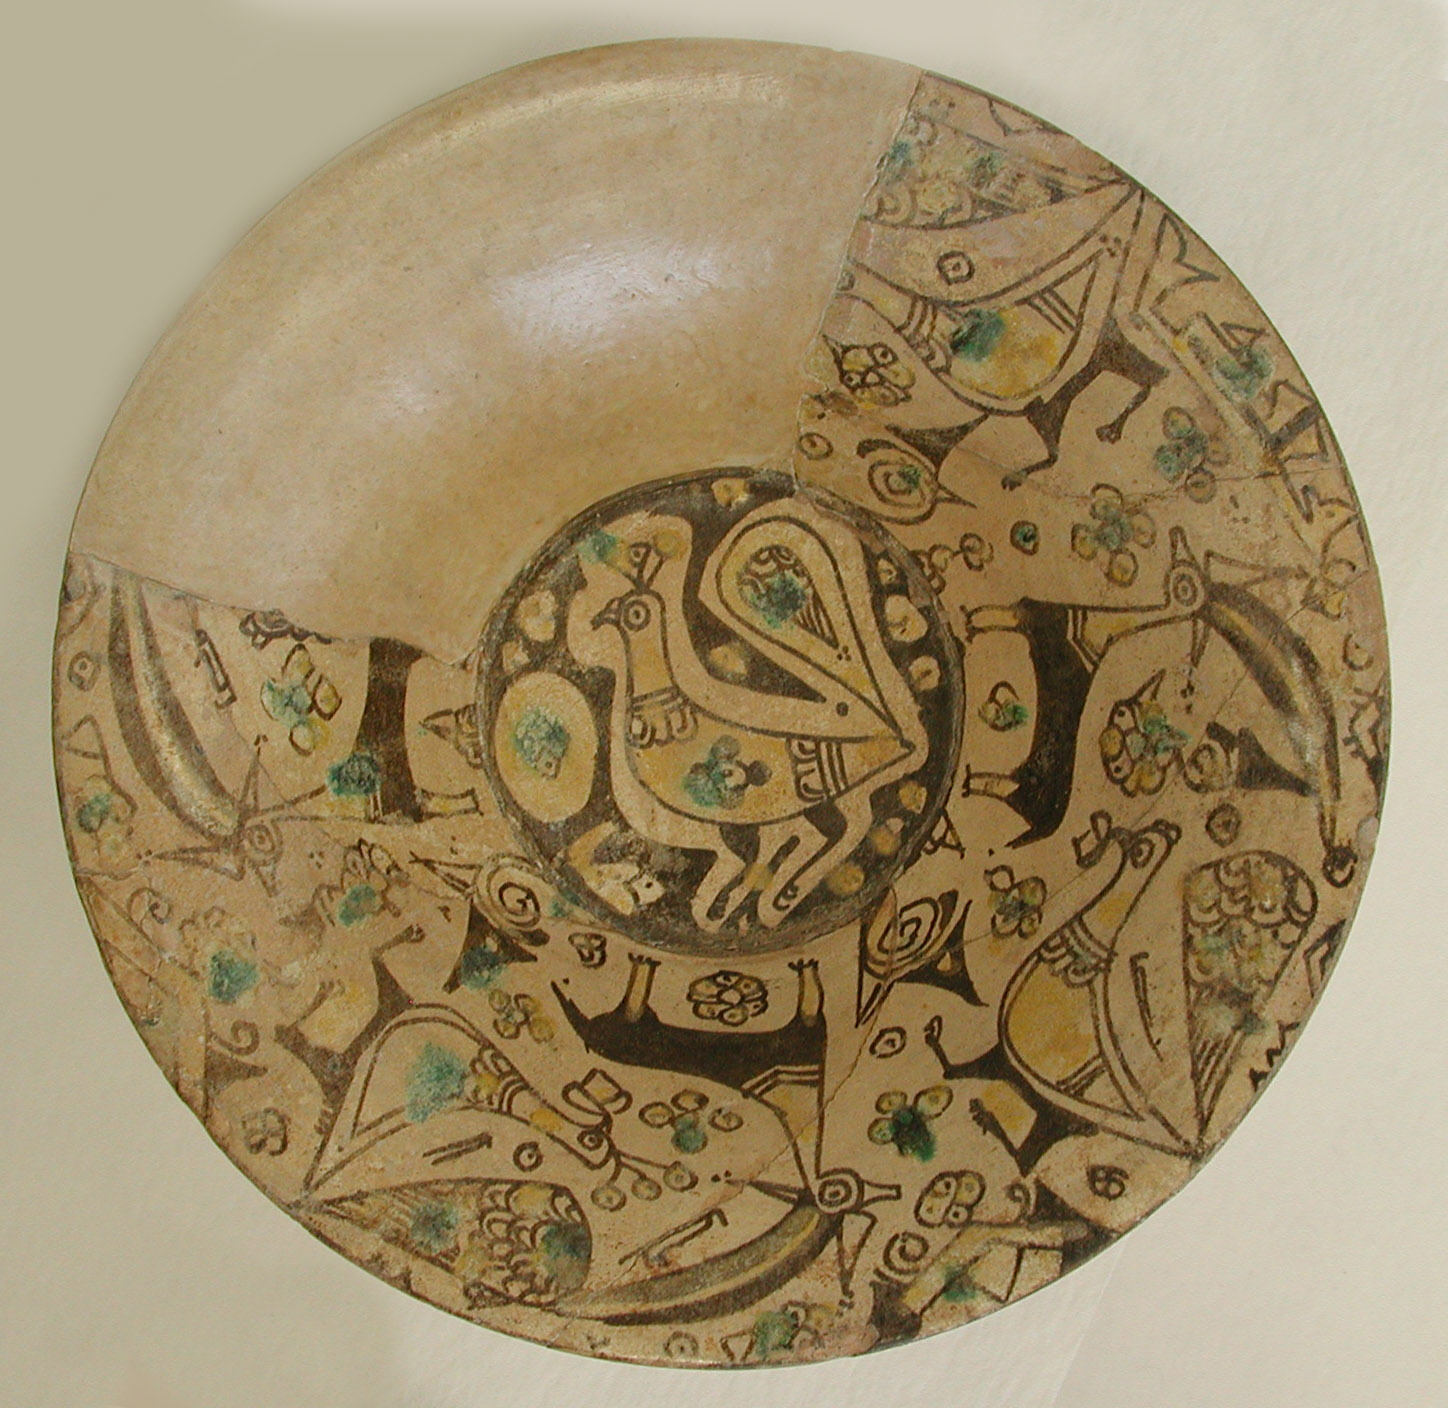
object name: bowl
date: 801-1000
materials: earthenware, glaze, pigment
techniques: painting, polychrome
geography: iran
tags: birds